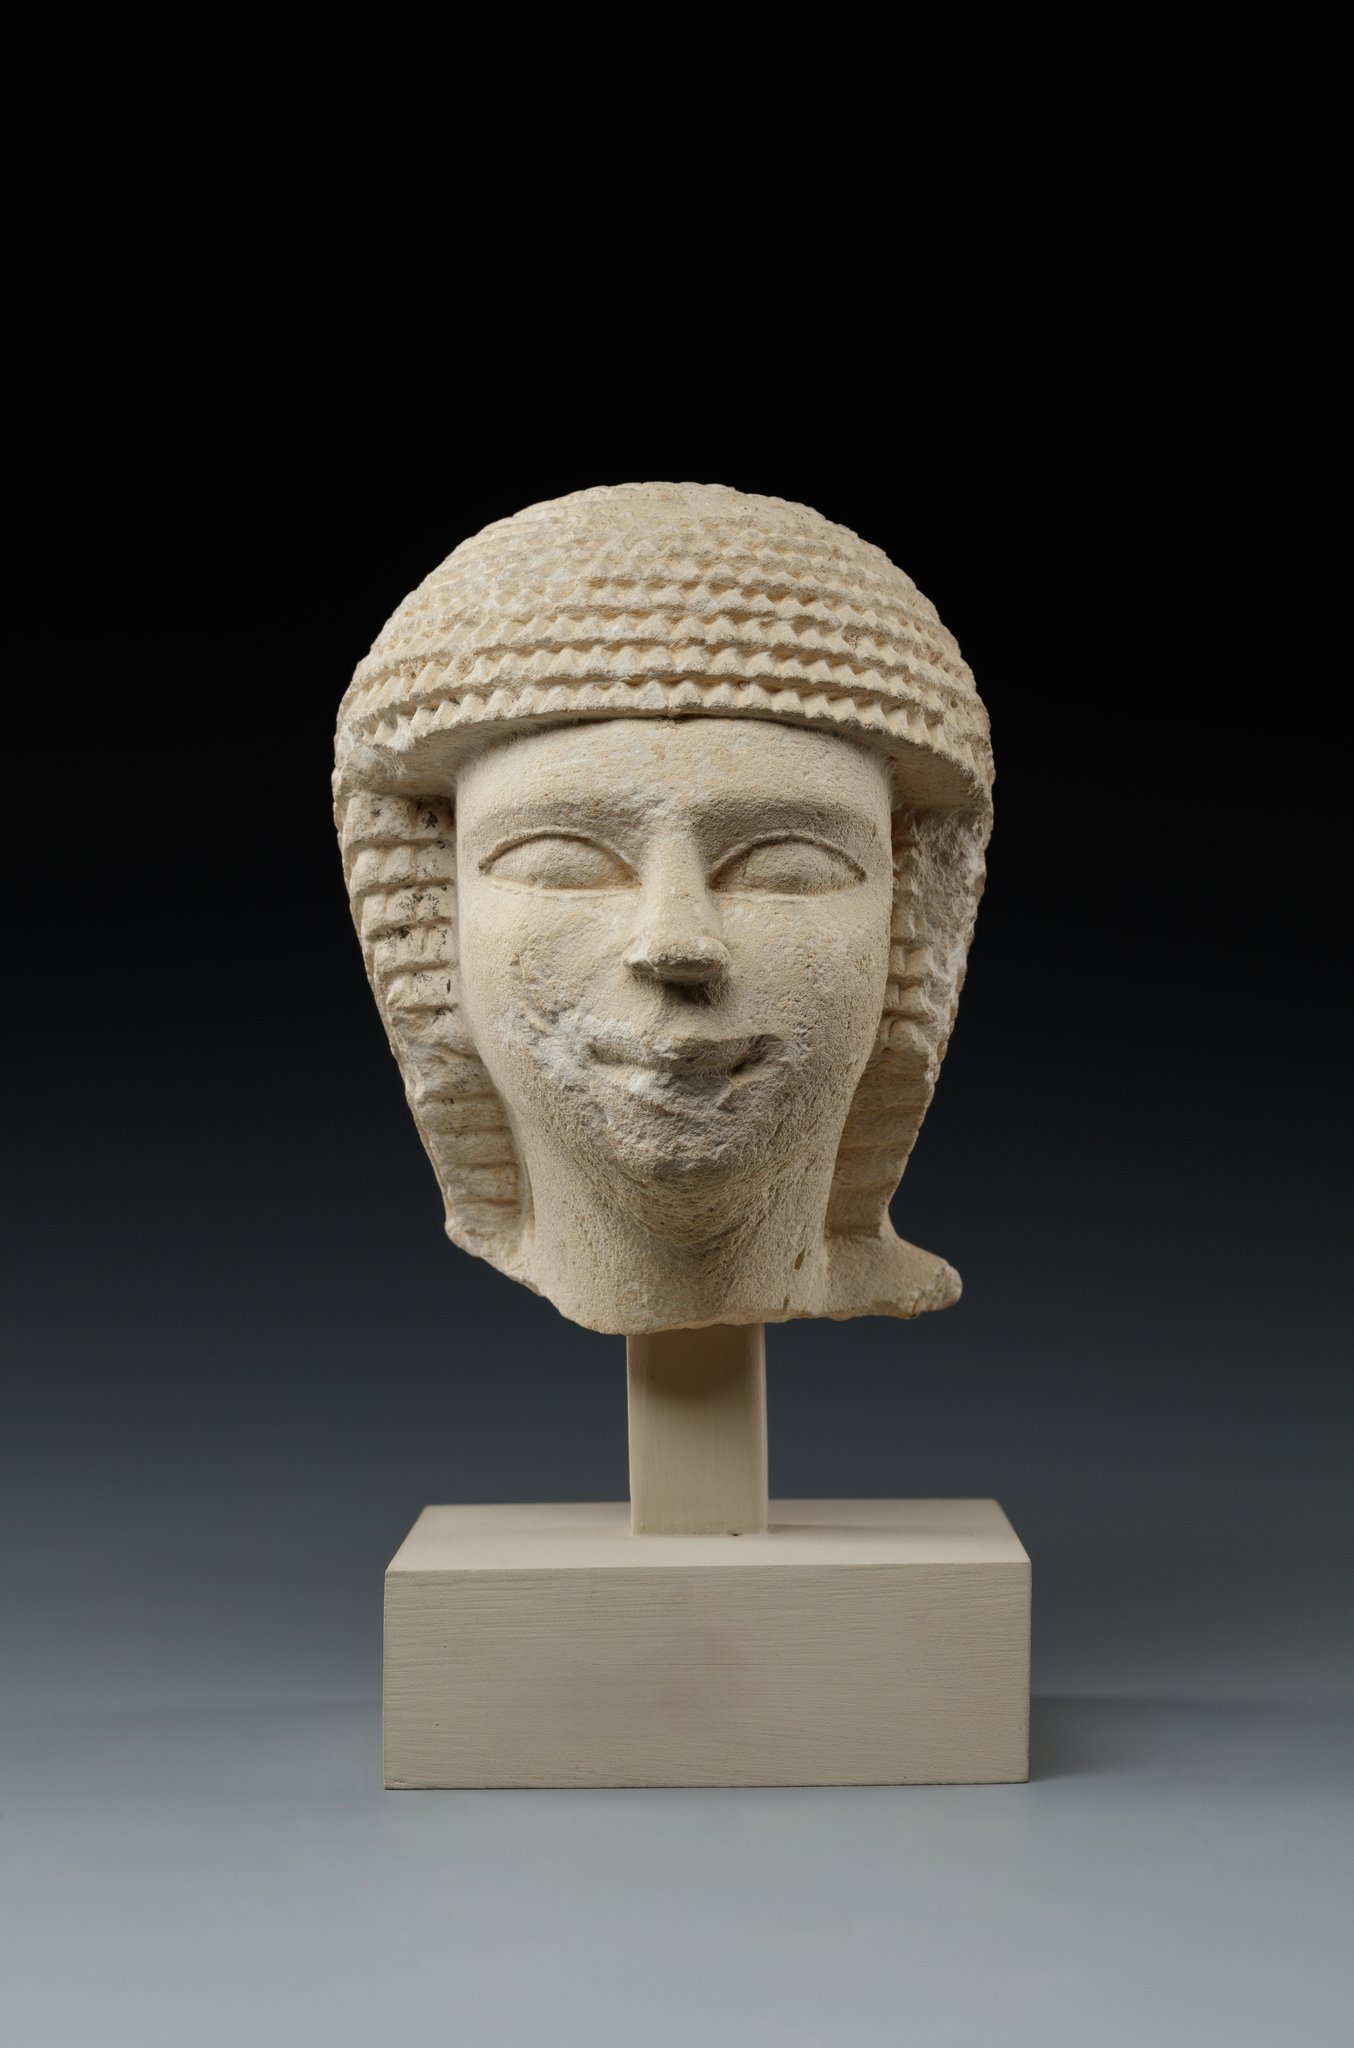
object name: head, male statue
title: Head of male statue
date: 2649-2100 BCE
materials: limestone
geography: egypt